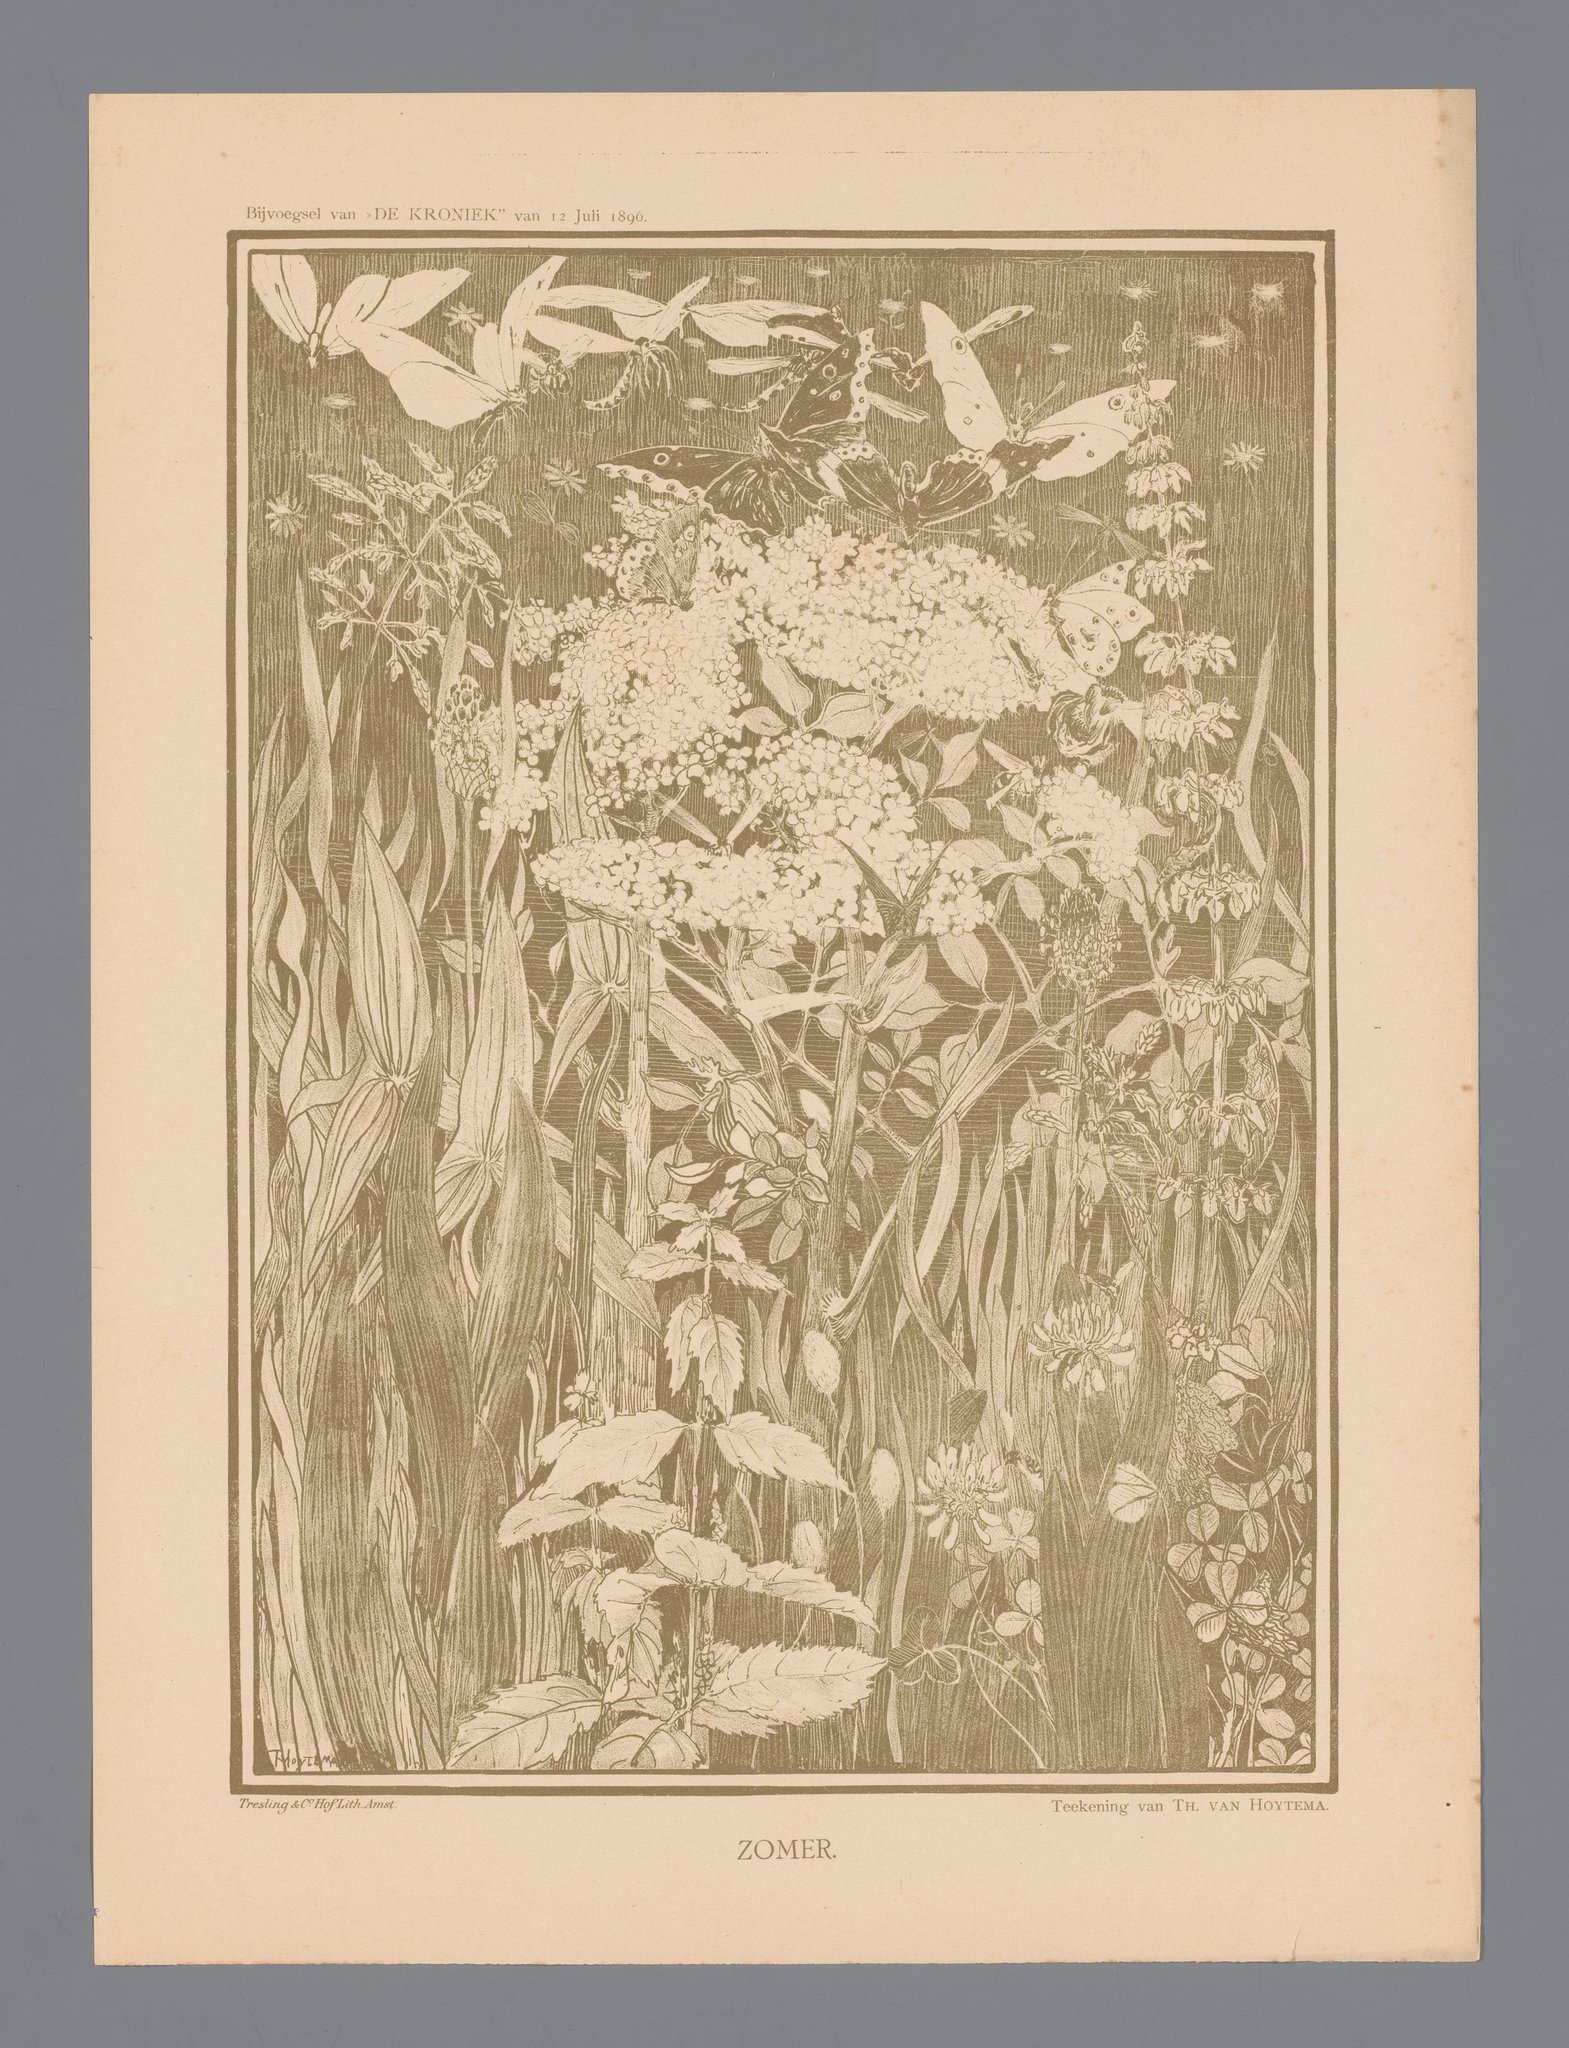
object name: print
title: Zomer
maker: theo van hoytema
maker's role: draughtsman, painter, print maker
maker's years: 1863-1917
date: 1896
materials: paper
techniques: lithograph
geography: amsterdam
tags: flowers, summer, 'aestas'; 'estate' (ripa), insects: butterfly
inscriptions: date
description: Prent uit het bijvoegsel van: De Kroniek 2 (1896), 12 juli 1896.